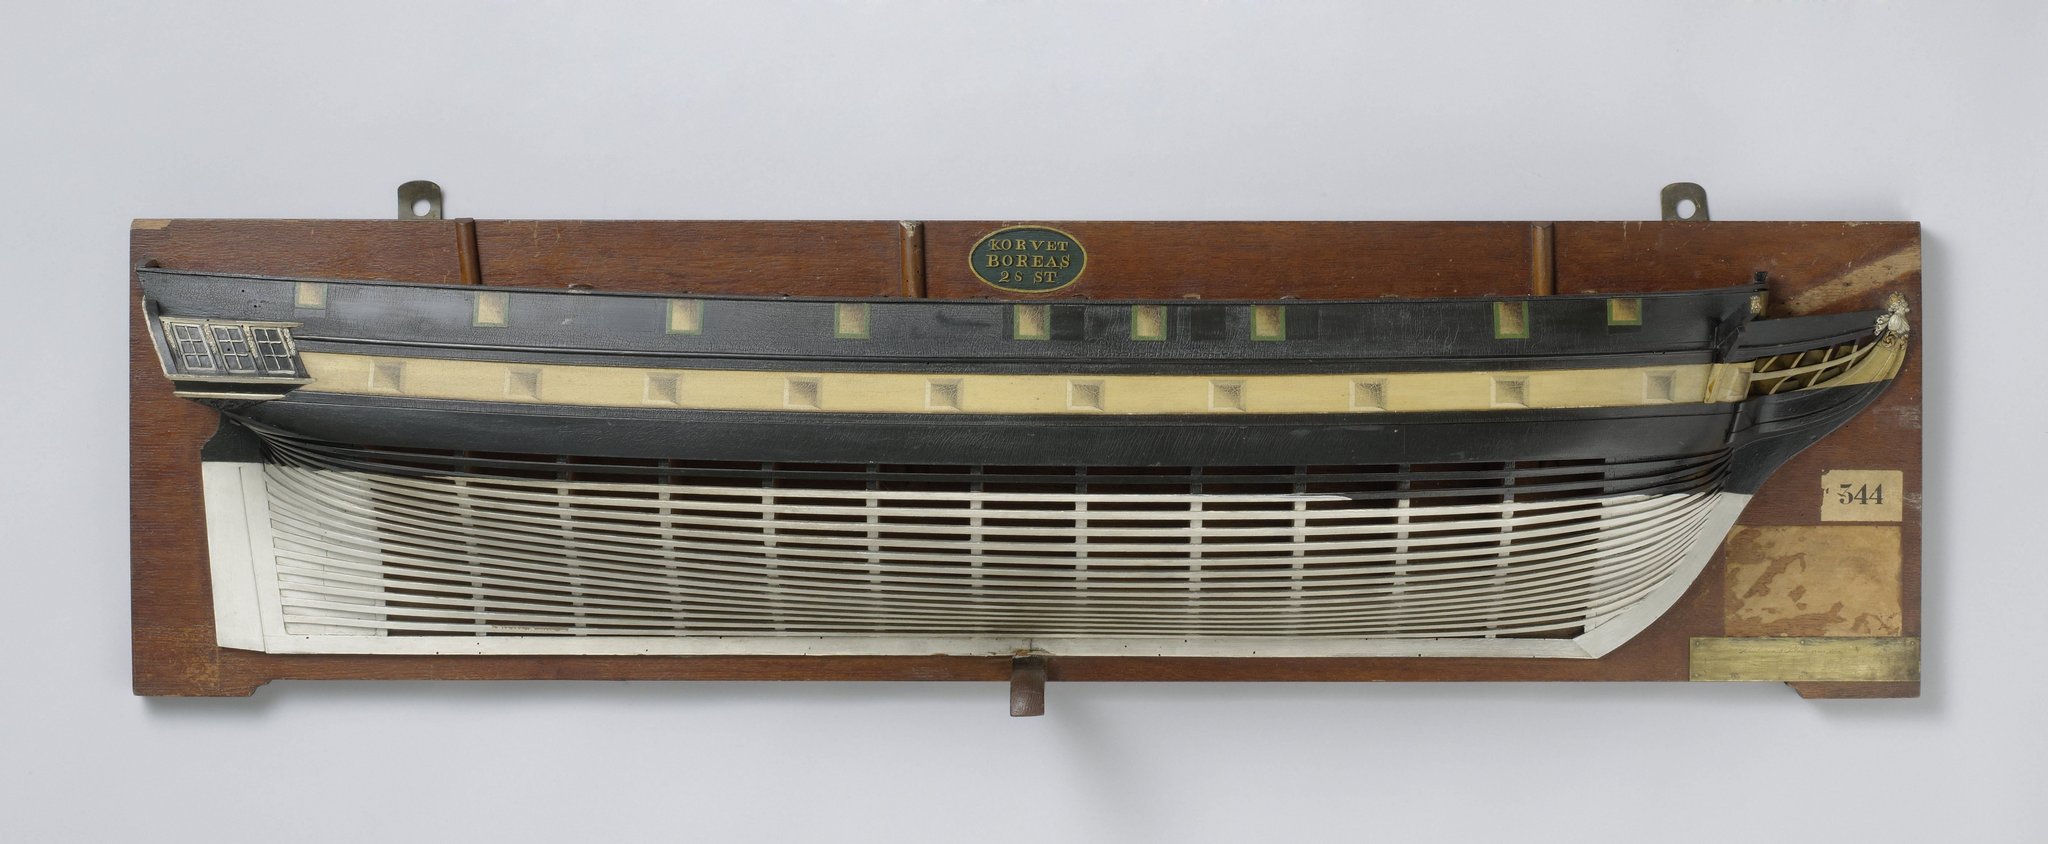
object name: ship model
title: Half Model of a 28-Gun Sloop of War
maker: Anonymous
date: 1828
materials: brass, wood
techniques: polychromy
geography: flushing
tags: boreas (schip)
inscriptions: inscription, top centre, on a blue roundel, painted: ‘KORVET / BOREAS / 28 ST’, label, bottom right: ‘344’ former inventory label, scale, bottom right: brass scale in inches, inscription, bottom right, on a piece of paper, in ink: ‘[...]’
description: Gepolychromeerd mallenmodel (stuurboord) van een driemaster, de huid boven het barkhout gesloten. Eén en twintig geschutpoorten verdeeld over twee dekken. Het schegbeeld is een gekroond mannelijk borstbeeld. Op de kraanbalk een leeuwenkop. Gewrongen spiegel, bijna plat wulf, hek en zijgalerij van één verdieping, met snijwerk versierd; roer met ronde roerkoning (Soetermeer's versie). Zeeg naar voor en achter iets oplopend, één barkhout en één reehout. Gepiekt rondspant. Schaal 1:40 (schaal op model).